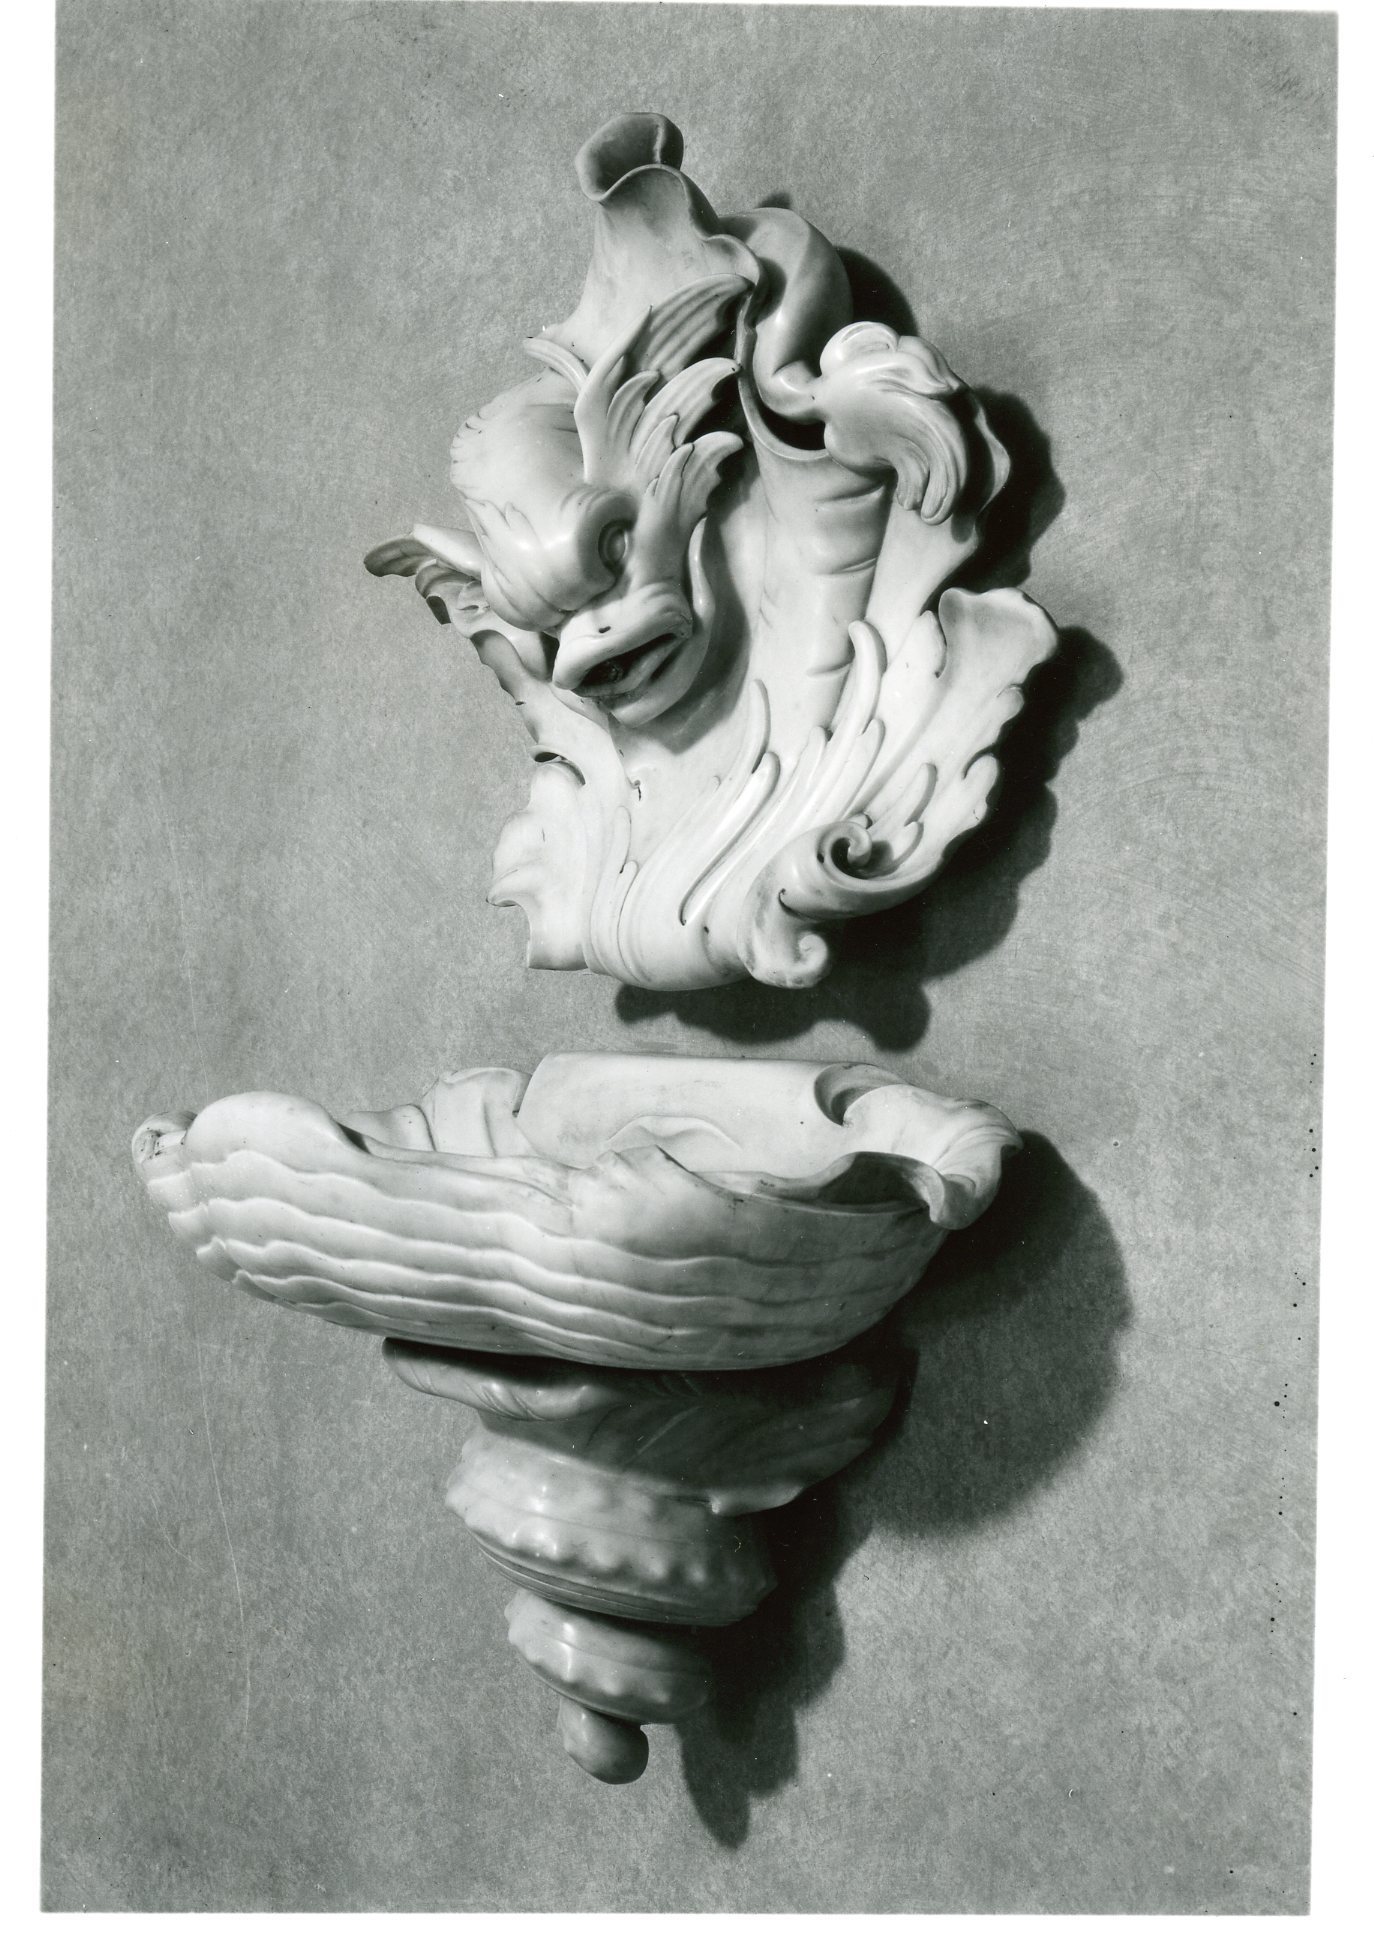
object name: wall fountain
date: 1734-1766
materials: marble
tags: fountains